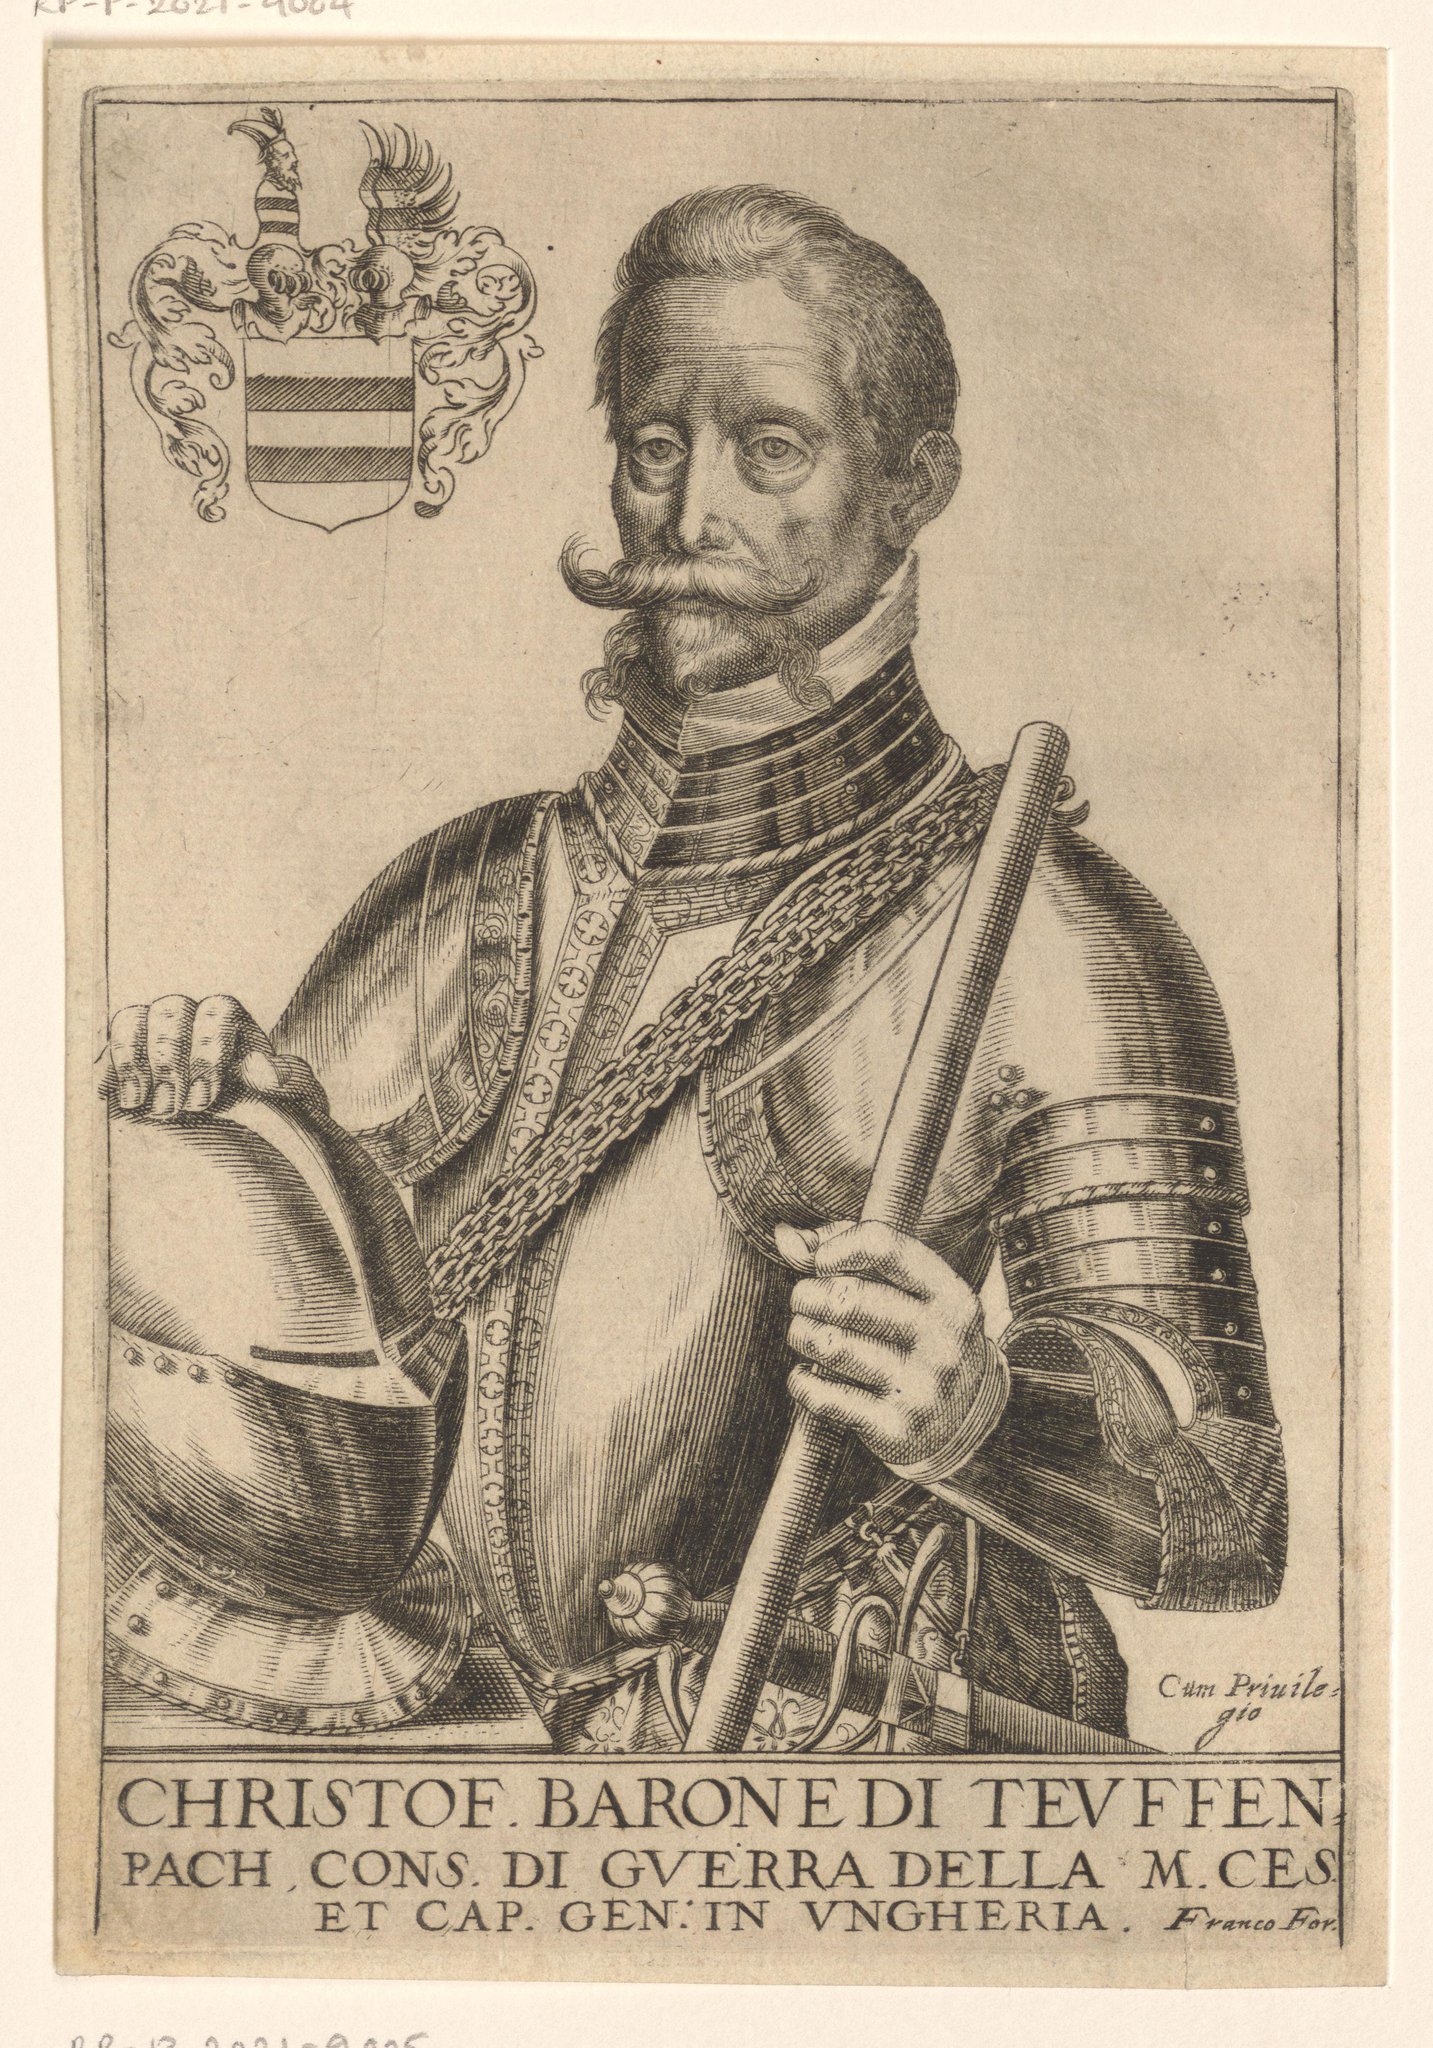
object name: print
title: Portret van Christoph von Teuffenbach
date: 1596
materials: paper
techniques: engraving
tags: prague, helmet, commander-in-chief, general, marshal, armour, historical persons, baton of general, armorial bearing, heraldry